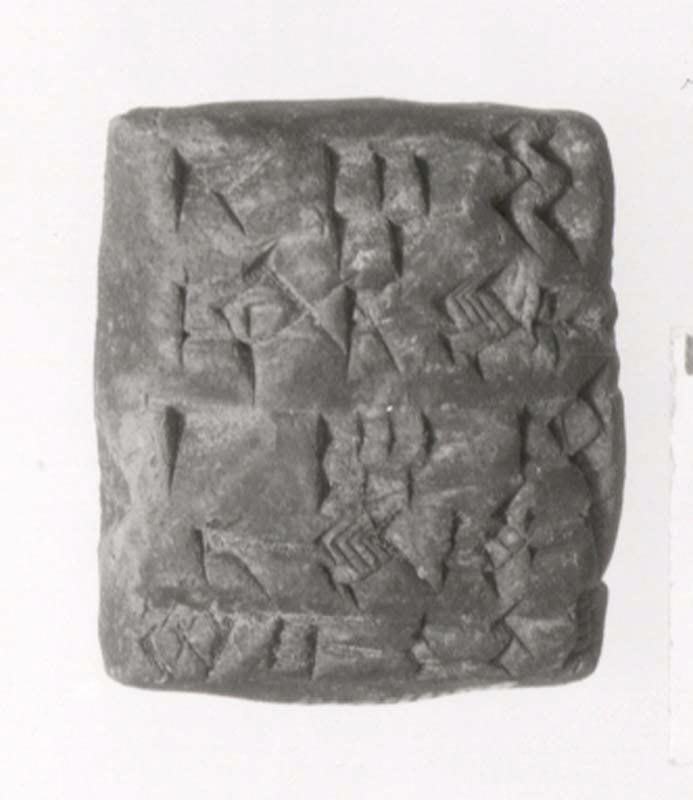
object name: cuneiform tablet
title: Cuneiform tablet: receipt of reeds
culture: neo-sumerian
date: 2040 BCE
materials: clay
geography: mesopotamia